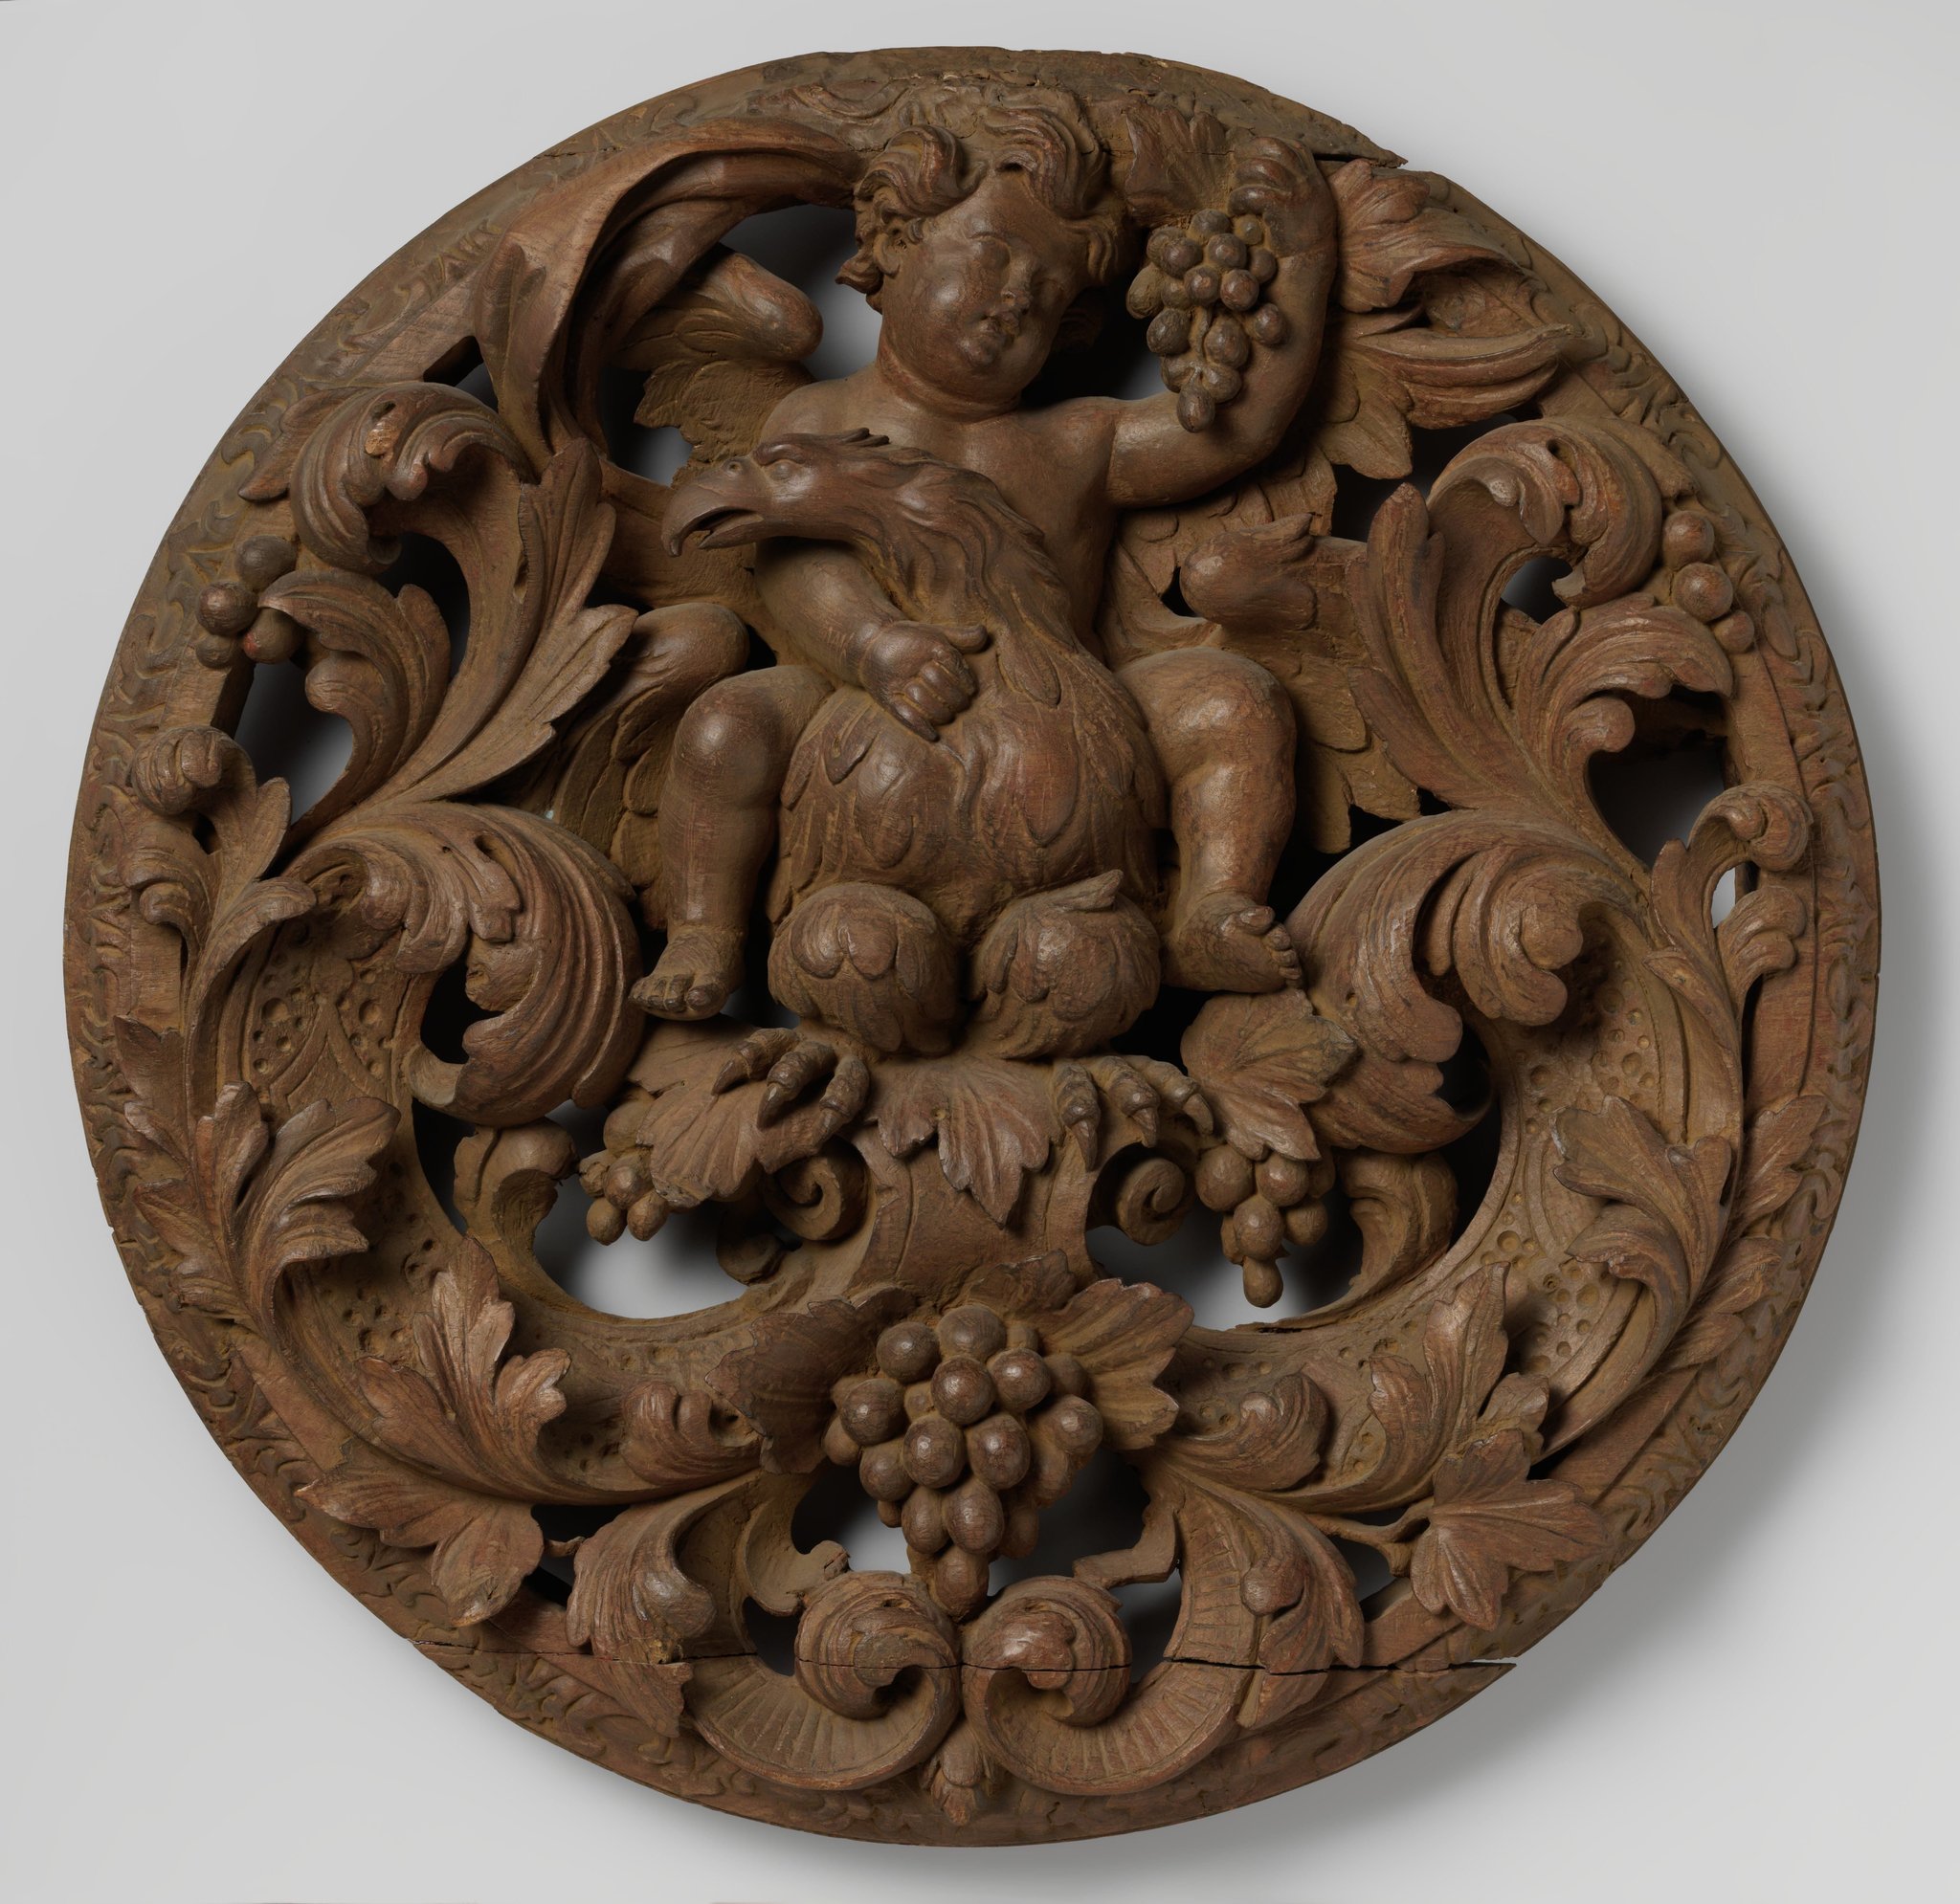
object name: woodcarving visual work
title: Adelaar in aangeschoten toestand getemd en bereden door een kleine Bacchus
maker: Anonymous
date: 1750-1800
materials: metal, wood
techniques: forging, painted, carving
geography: netherlands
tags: colombo, weltevreden, gouverneur-generaal, petrus albertus van der parra